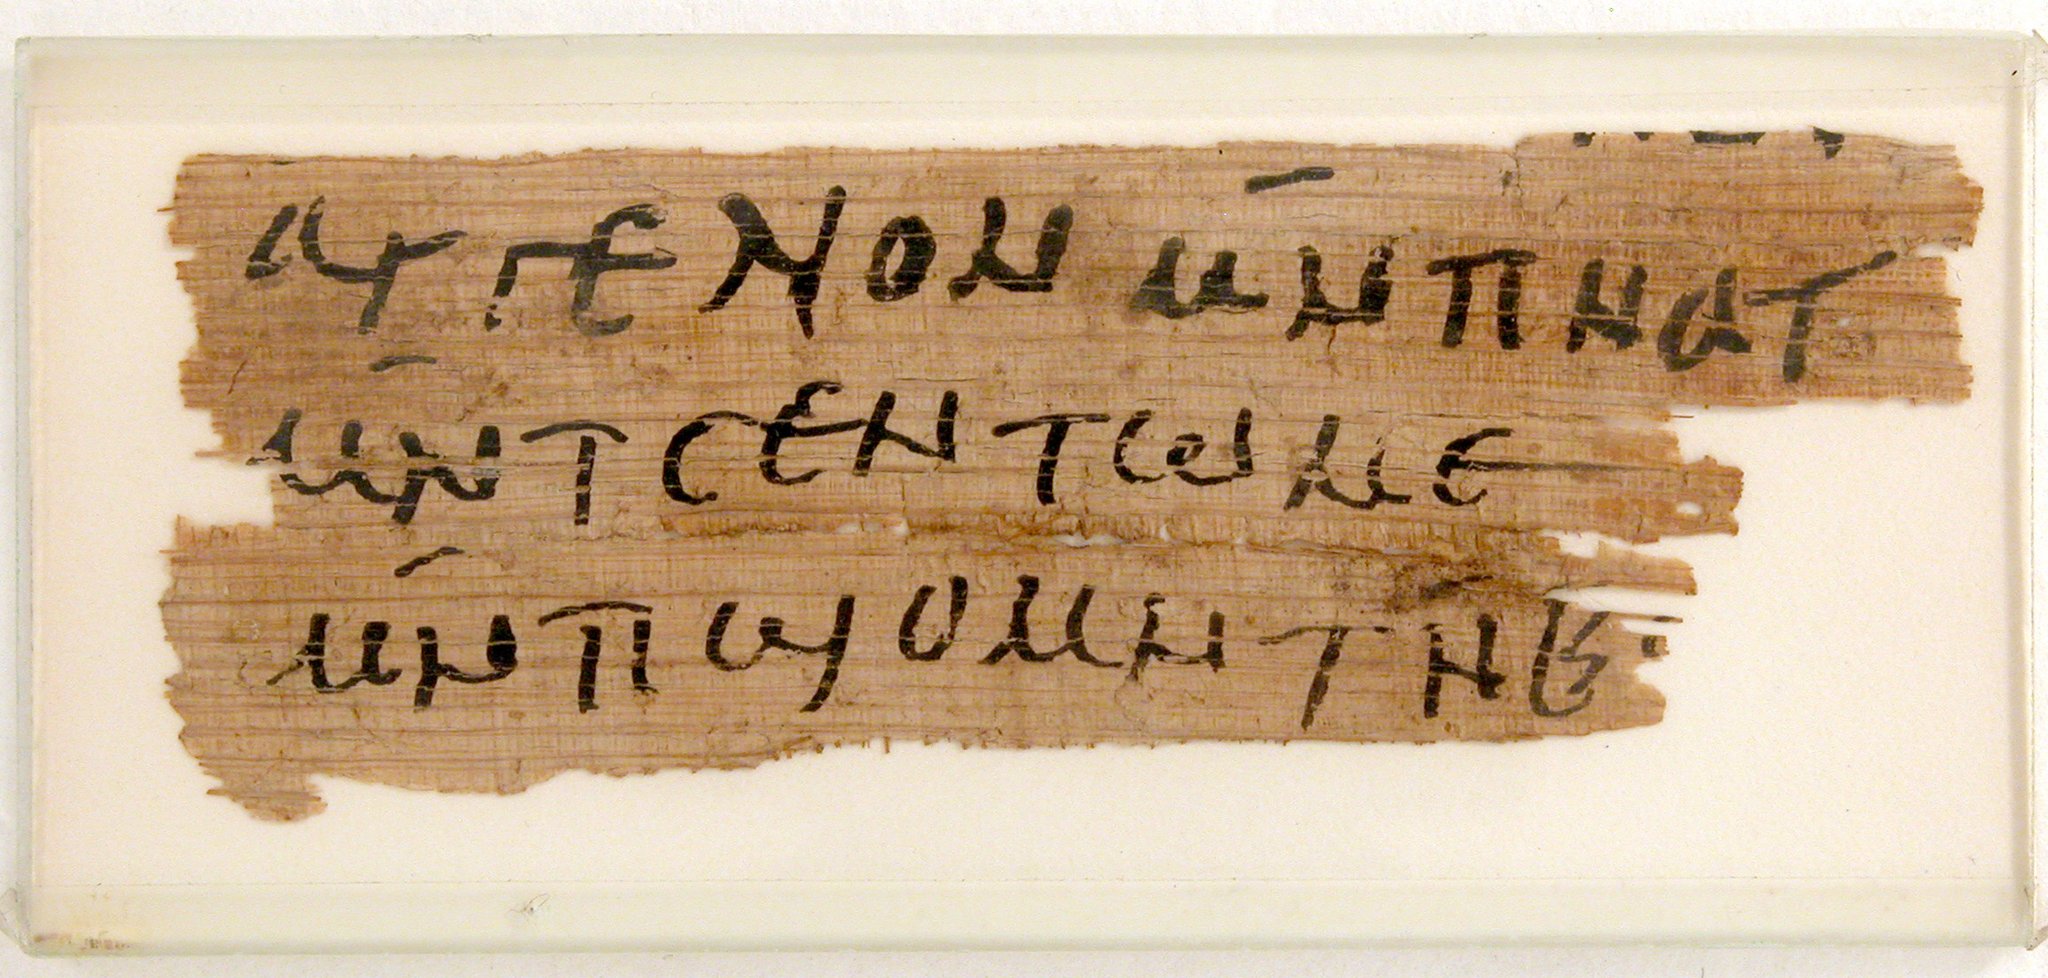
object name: fragment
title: Papyrus Fragment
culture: coptic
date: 601-700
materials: ink, papyrus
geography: egypt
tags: coptic,documents